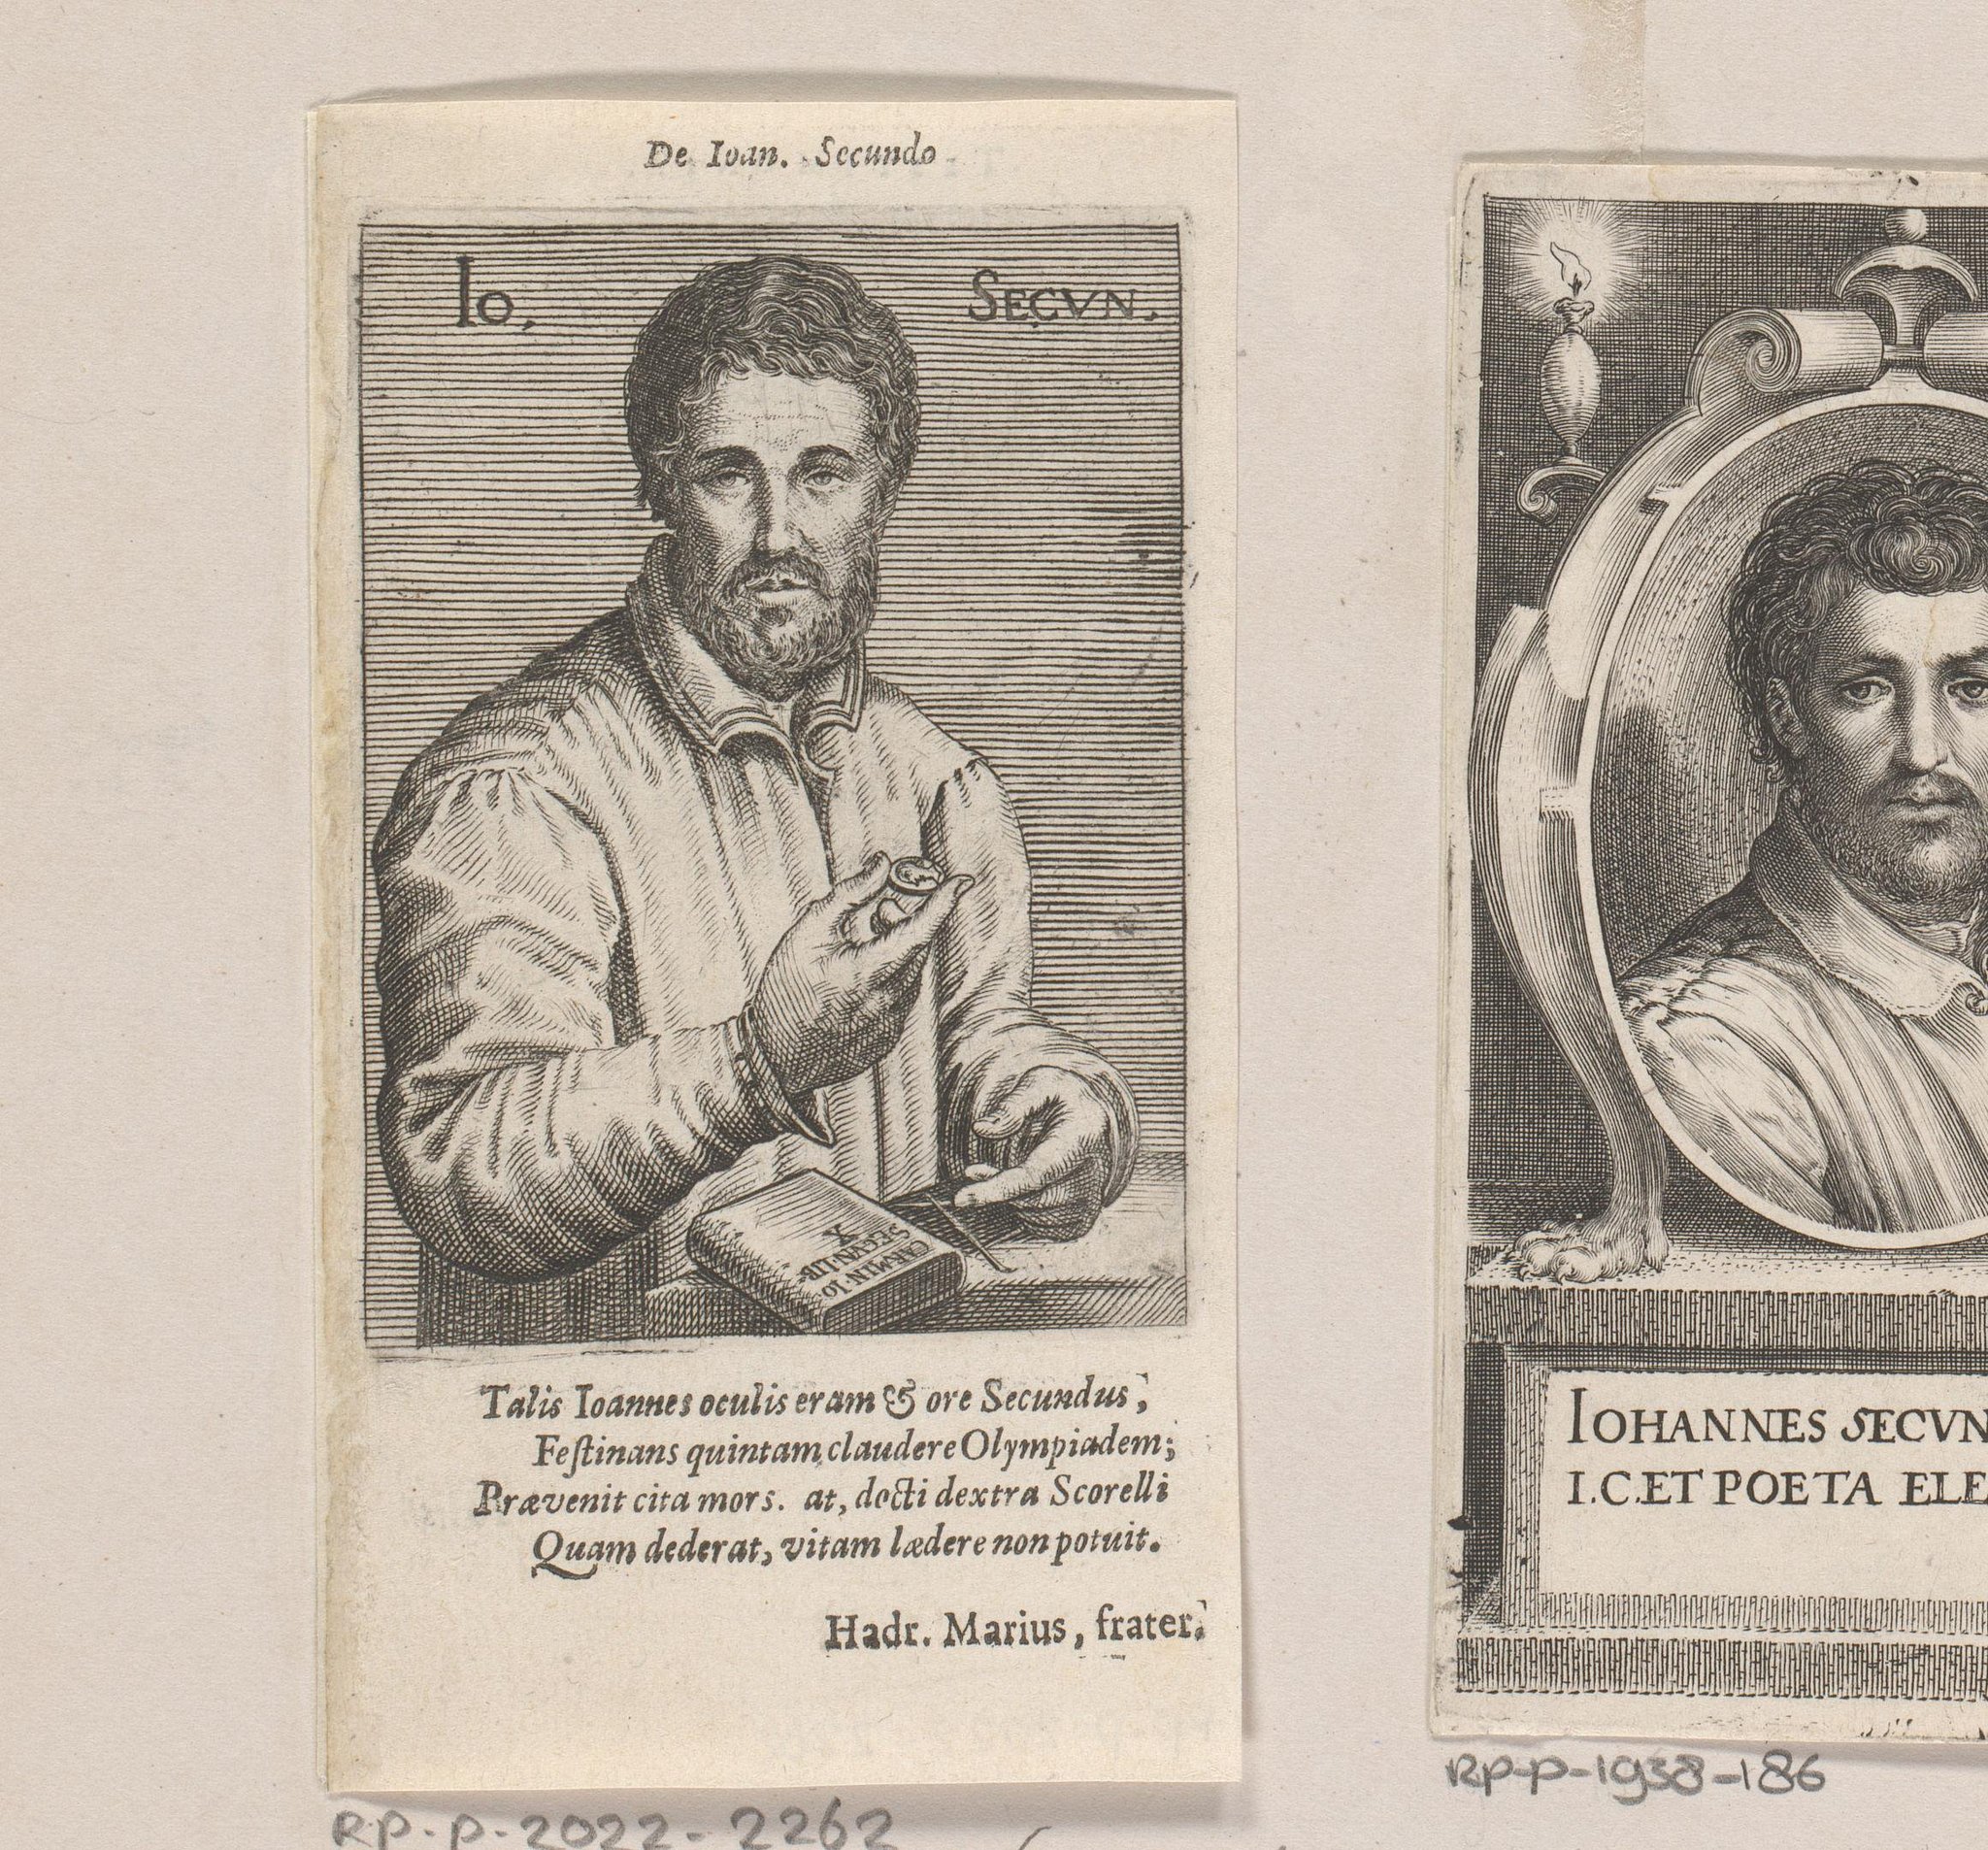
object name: print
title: Portret van Janus Secundus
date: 1631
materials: paper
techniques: engraving, etching, letterpress printing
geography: leiden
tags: the hague, janus secundus, historical persons, portrait of a writer, writer, poet, author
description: Prent uit: Secundus, Janus en Pieter Schrijver. Iohannis Secundi Opera. Leiden: Franciscus Hegerus, 1631.